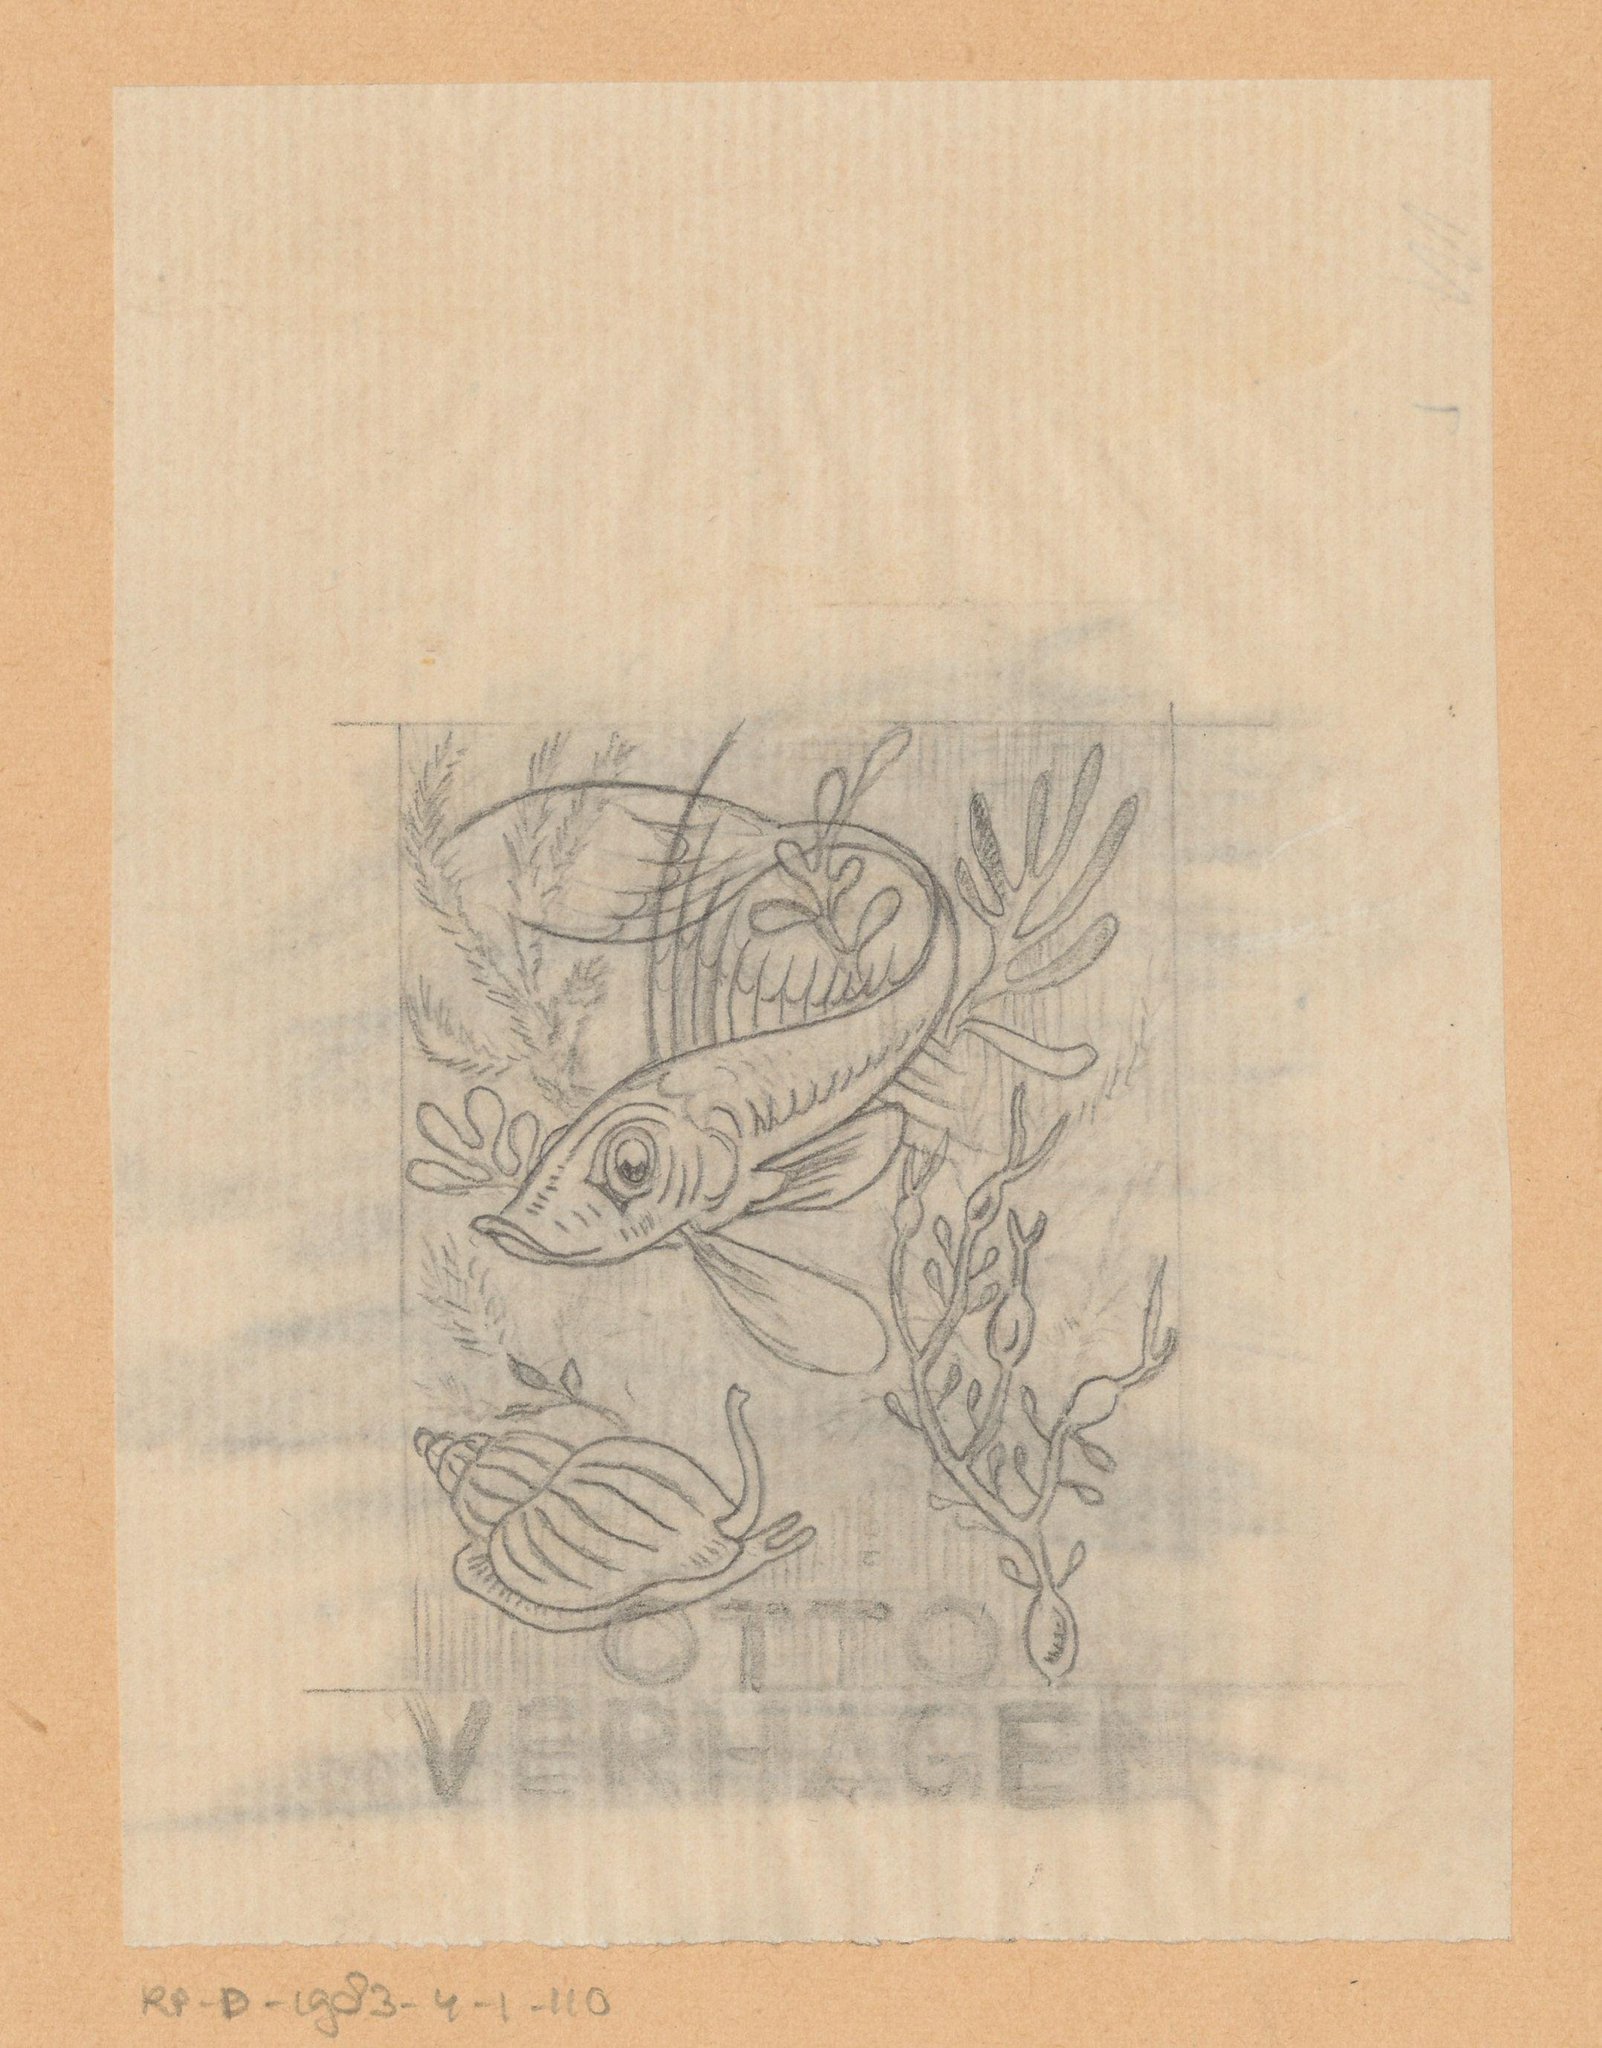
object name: design drawing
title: Ontwerptekening voor ex libris van Otto Verhagen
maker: otto verhagen (i)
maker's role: draughtsman, print maker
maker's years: 1885-1951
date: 1935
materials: paper, pencil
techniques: drawing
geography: netherlands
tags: the hague, print maker, draughtsman, otto verhagen (i), fishes, molluscs: snail